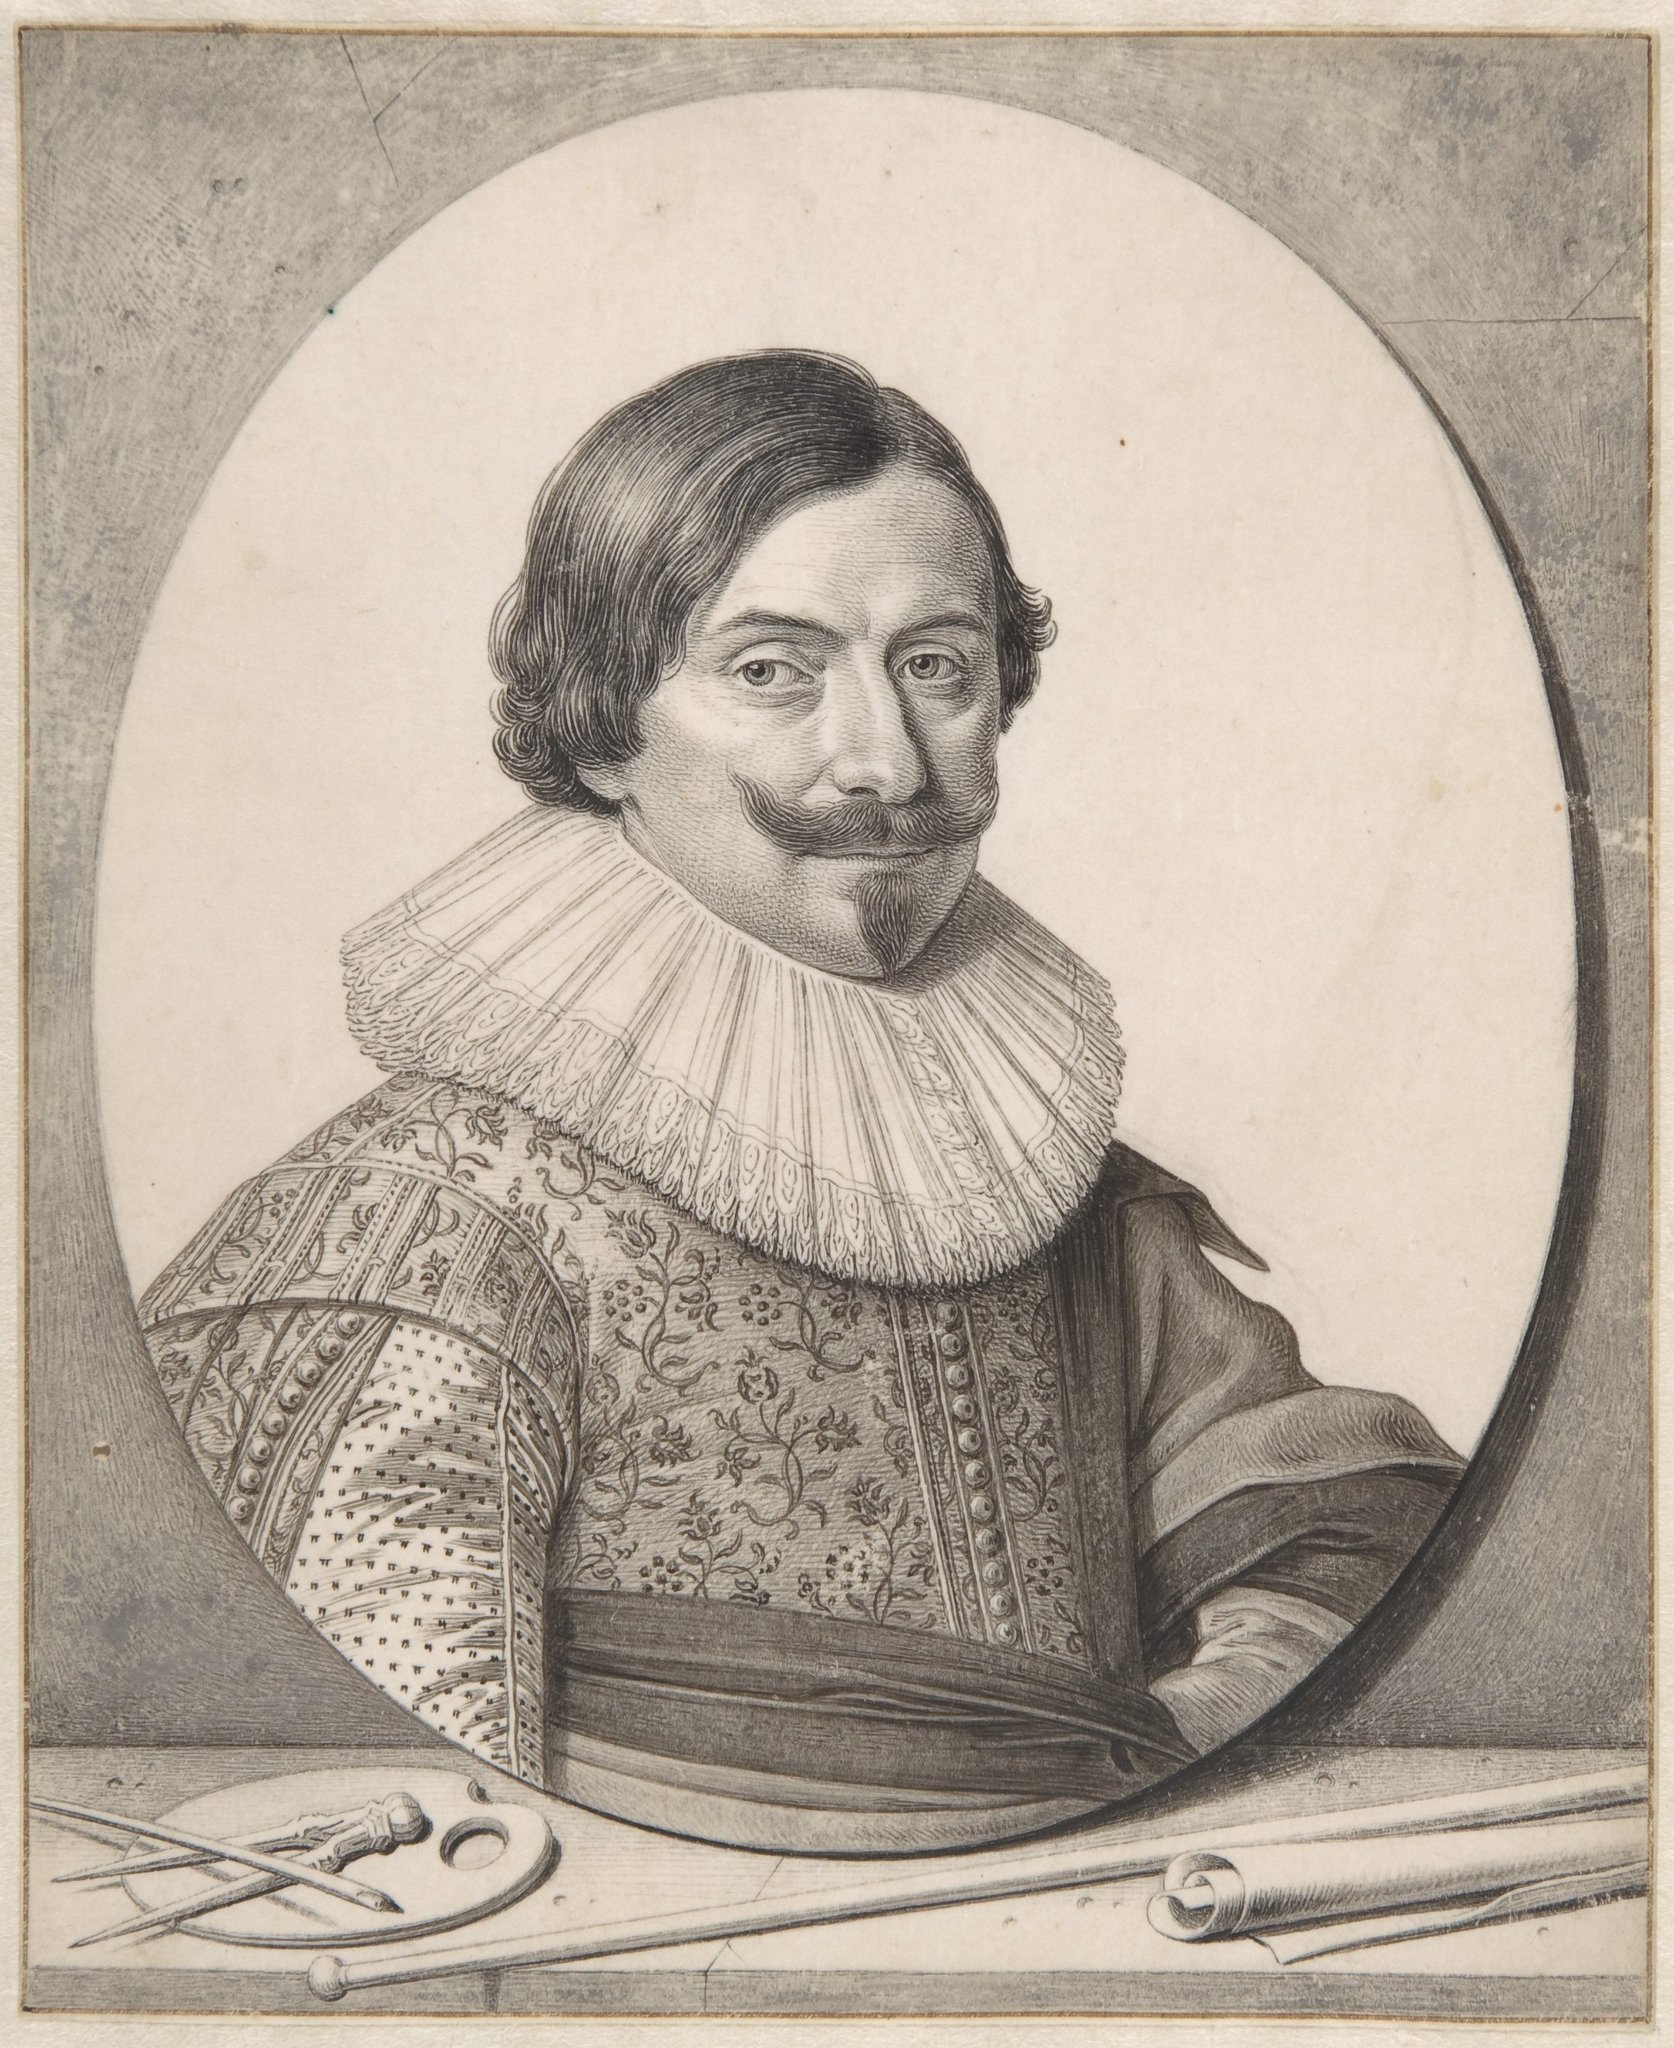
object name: drawing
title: Portrait of the Painter François Gysels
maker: david bailly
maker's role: artist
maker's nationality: dutch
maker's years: 1584-1657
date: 1620-1630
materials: graphite, ink, parchment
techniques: brush, pen, wash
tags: men,portraits,artists,palettes